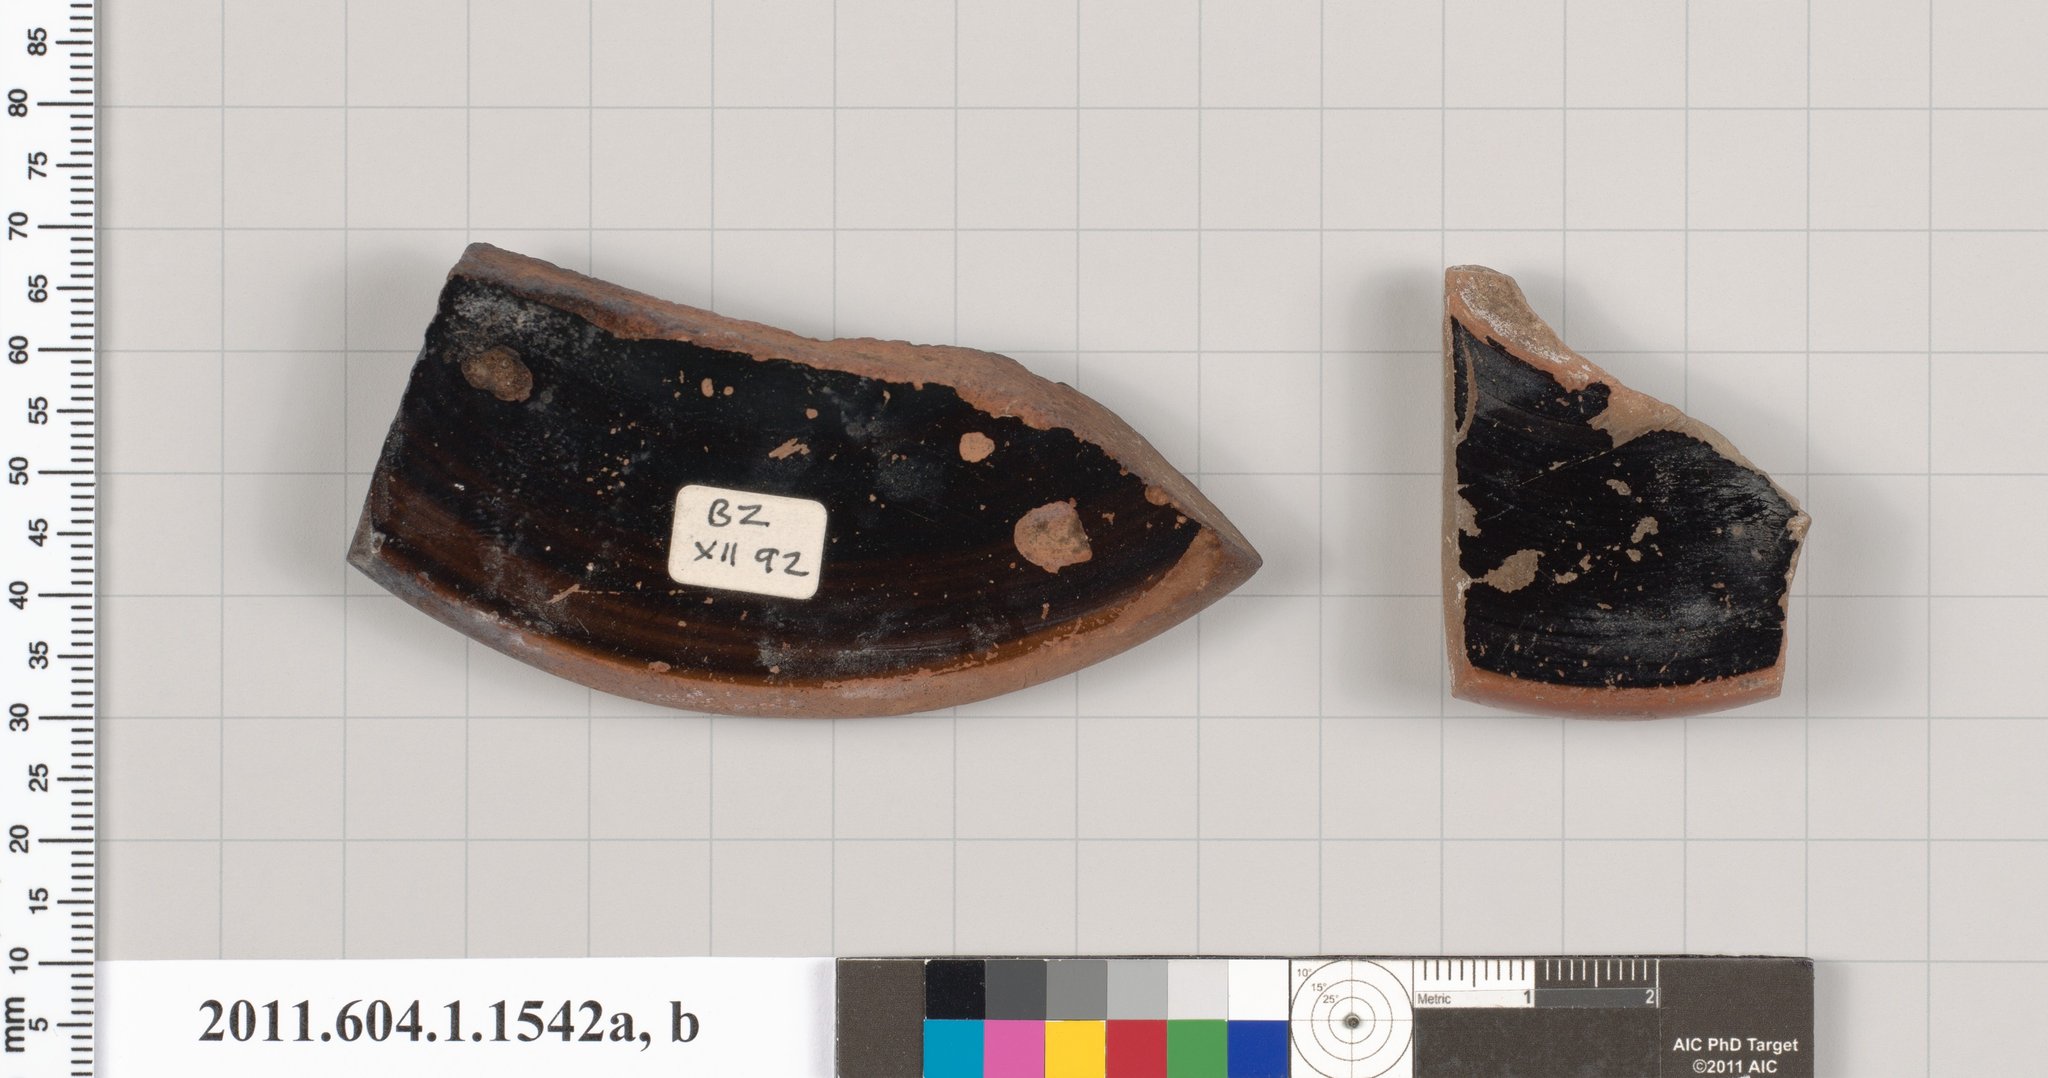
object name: kylix fragment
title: Terracotta fragments of kylikes (drinking cups)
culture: greek, attic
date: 500-401 BCE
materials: terracotta